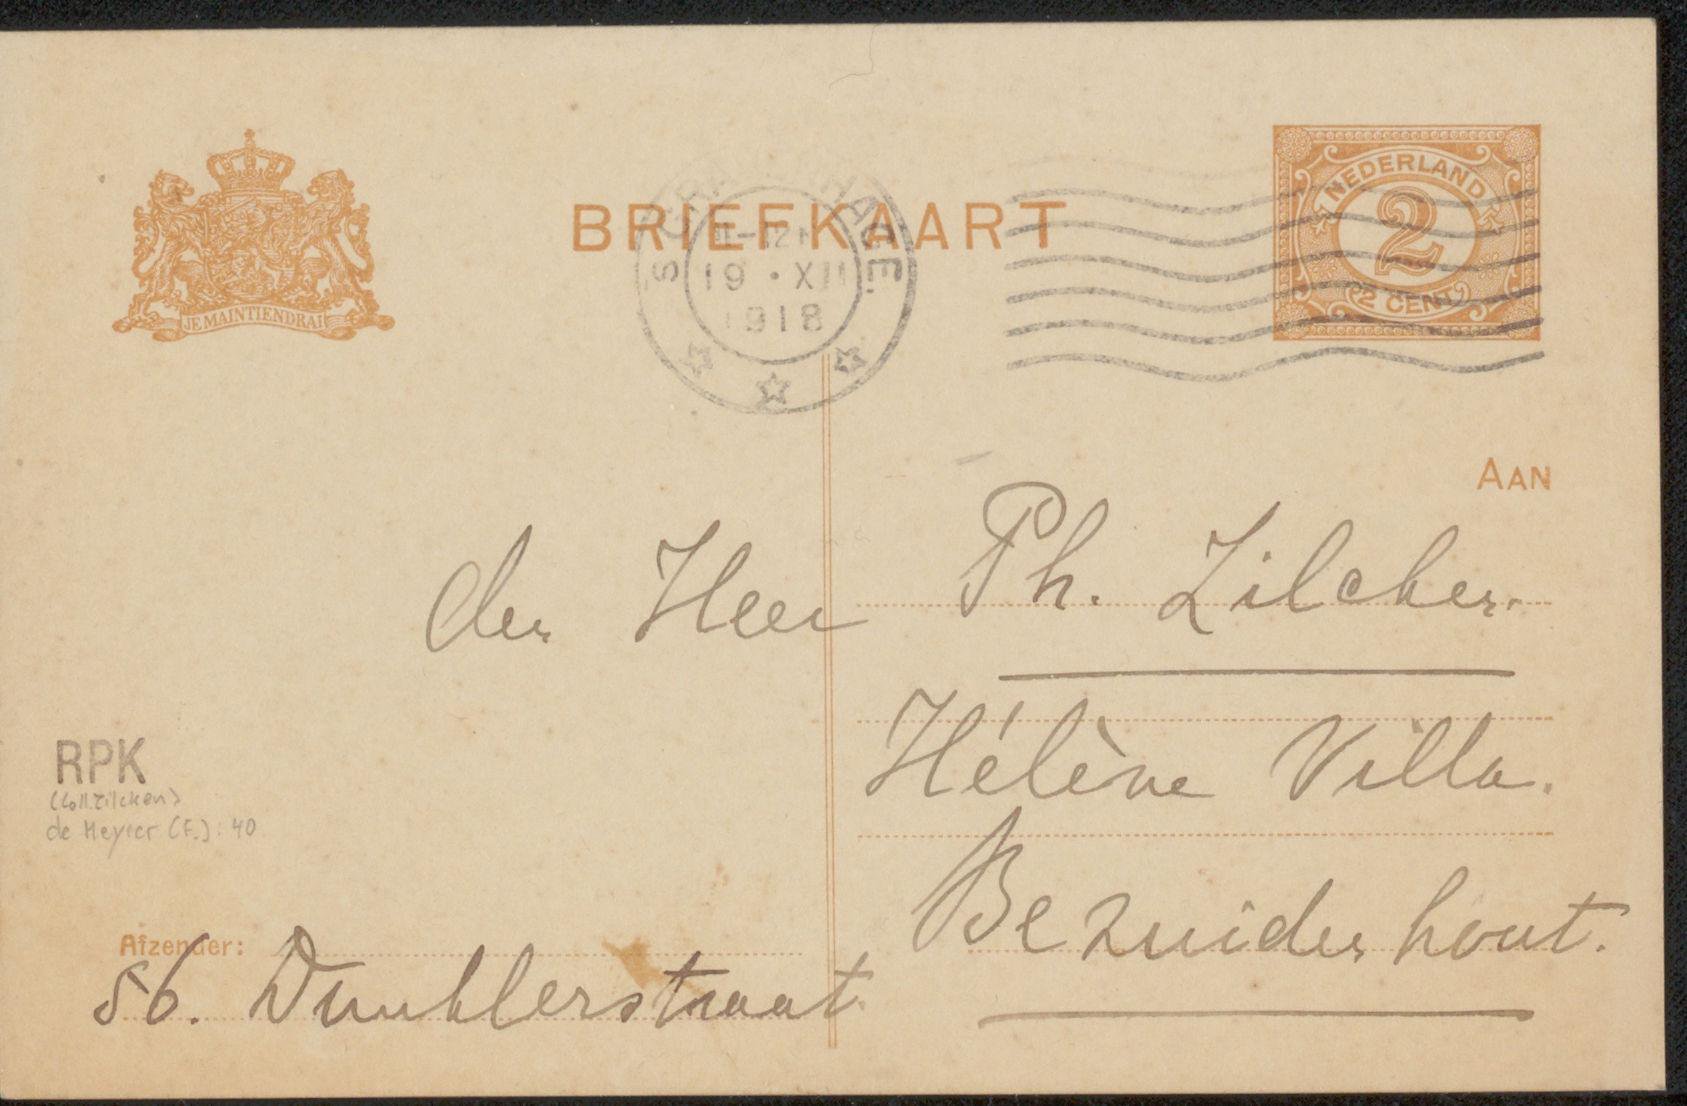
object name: postcard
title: Briefkaart aan Philip Zilcken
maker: fenna de meyier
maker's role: onderwijzer, schrijver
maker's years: 1874-1943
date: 1918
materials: cardboard, ink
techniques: pen, writing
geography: the hague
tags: painter, draughtsman, philip zilcken, diseases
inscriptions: collector's mark: ‘RPK’